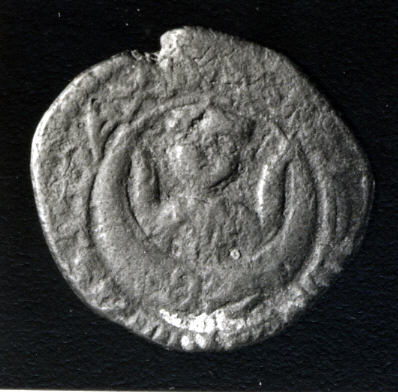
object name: coin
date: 1101-1300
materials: copper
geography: iraq